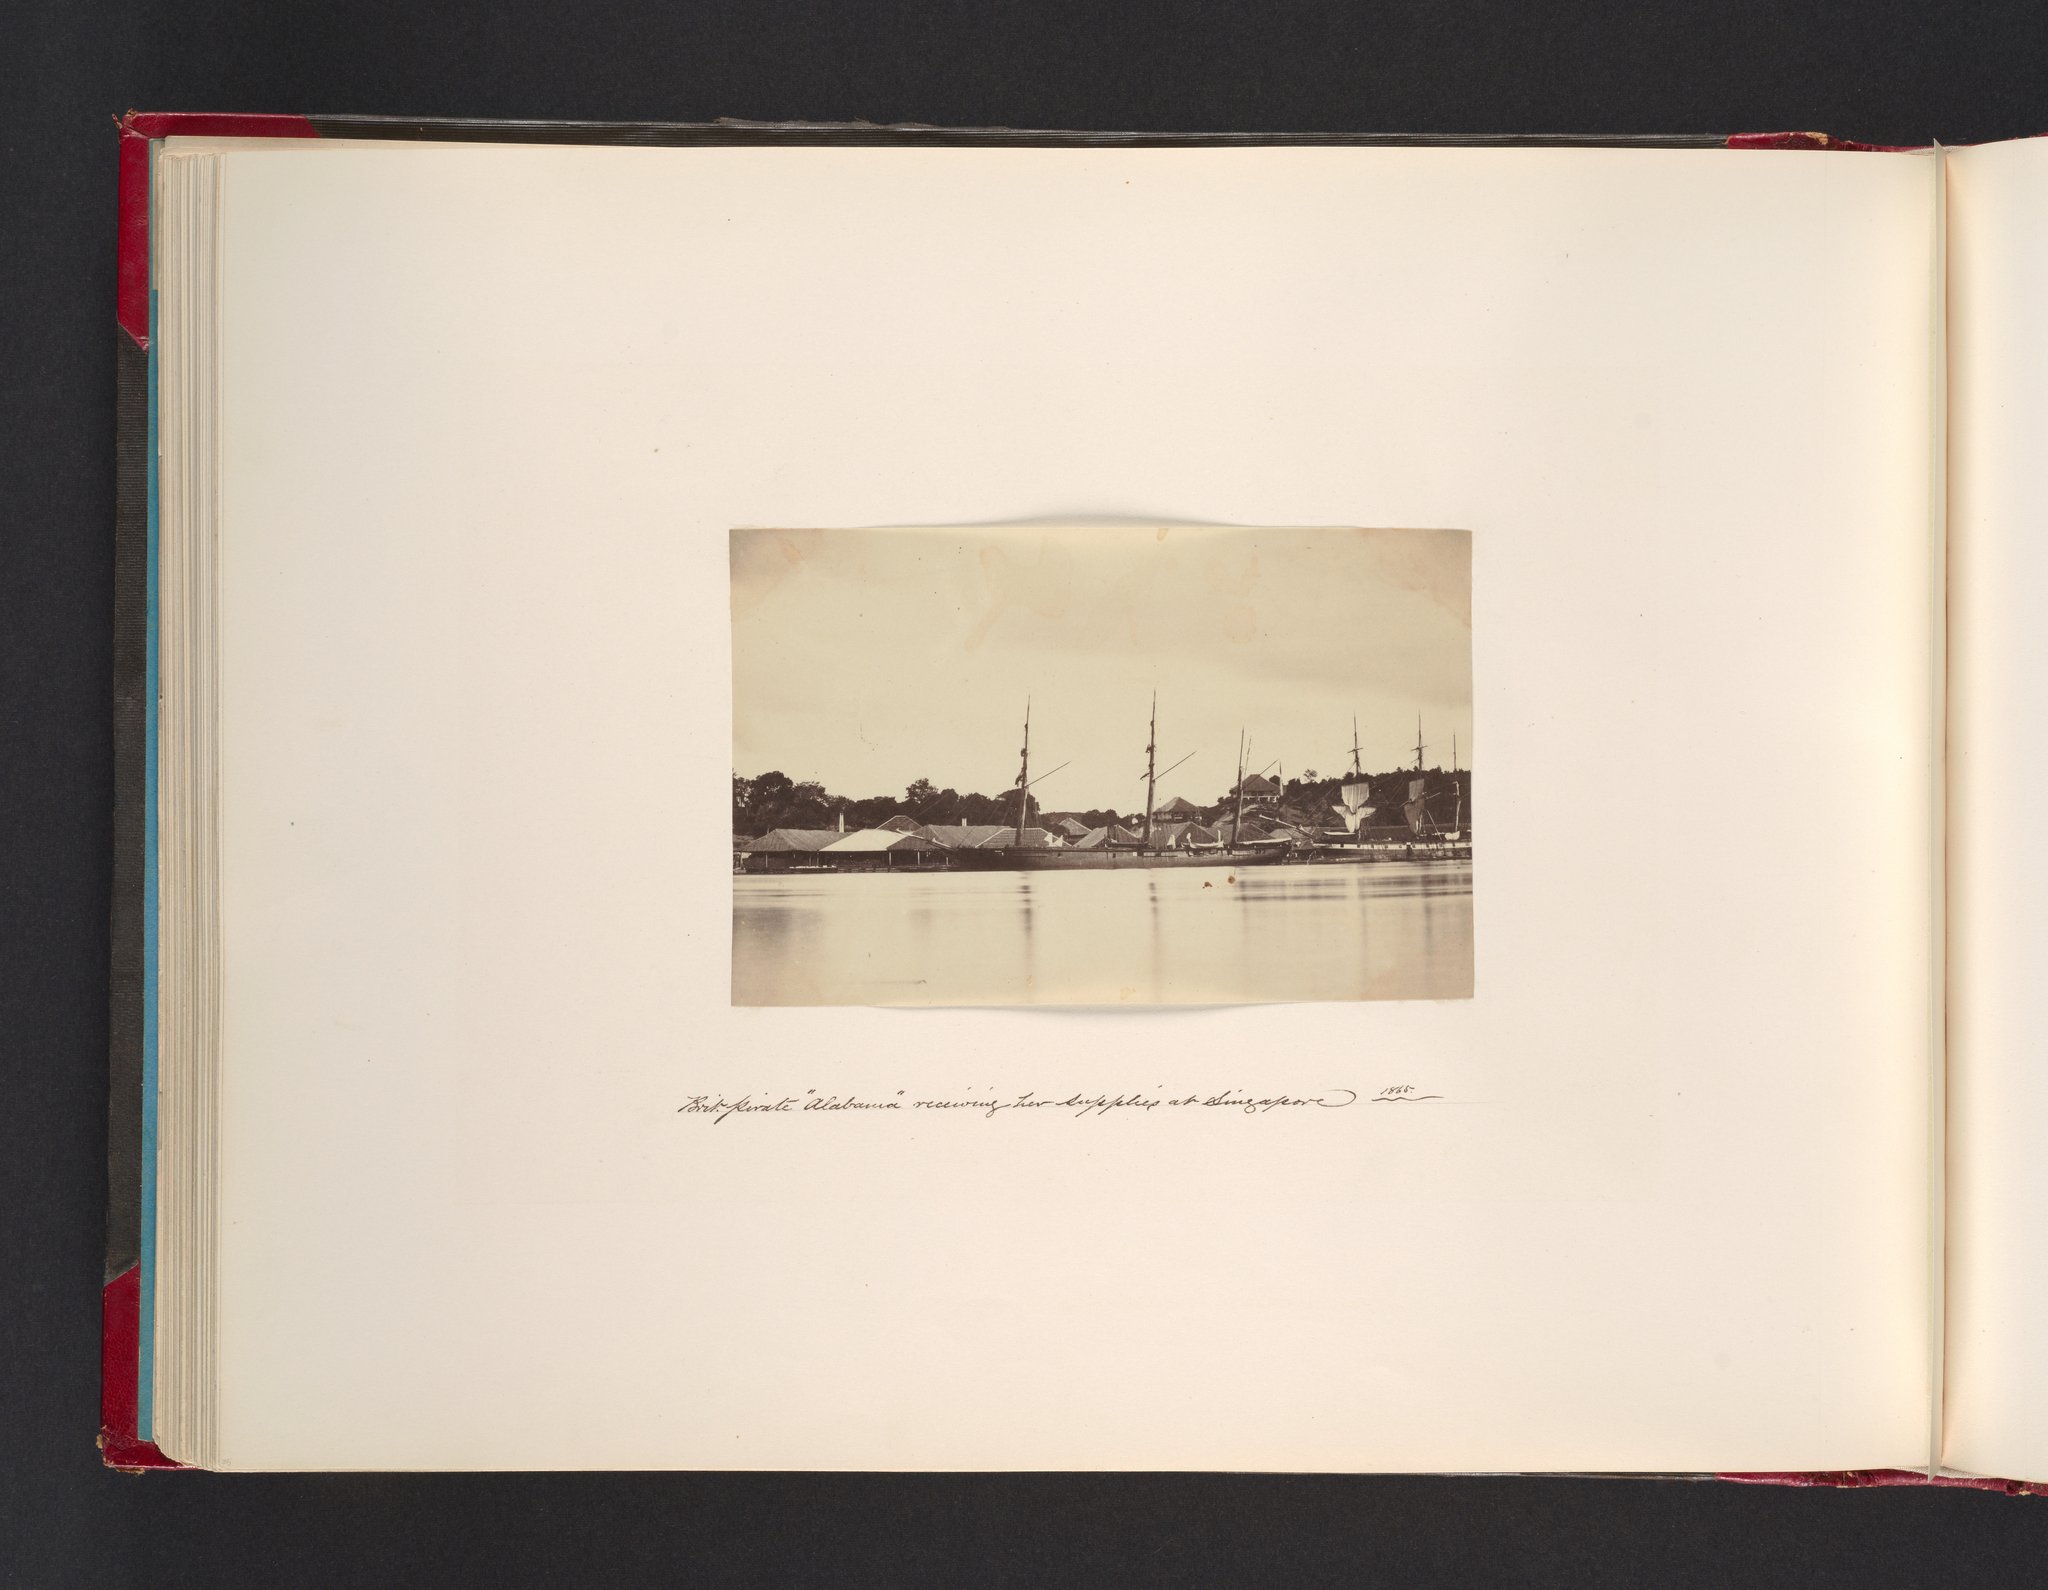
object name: photograph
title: Private "Alabama" Receiving Her Supplies at Singapore, 1865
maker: john thomson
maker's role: artist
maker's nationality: british, scottish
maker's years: 1837-1921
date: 1865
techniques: albumen silver print, glass negative